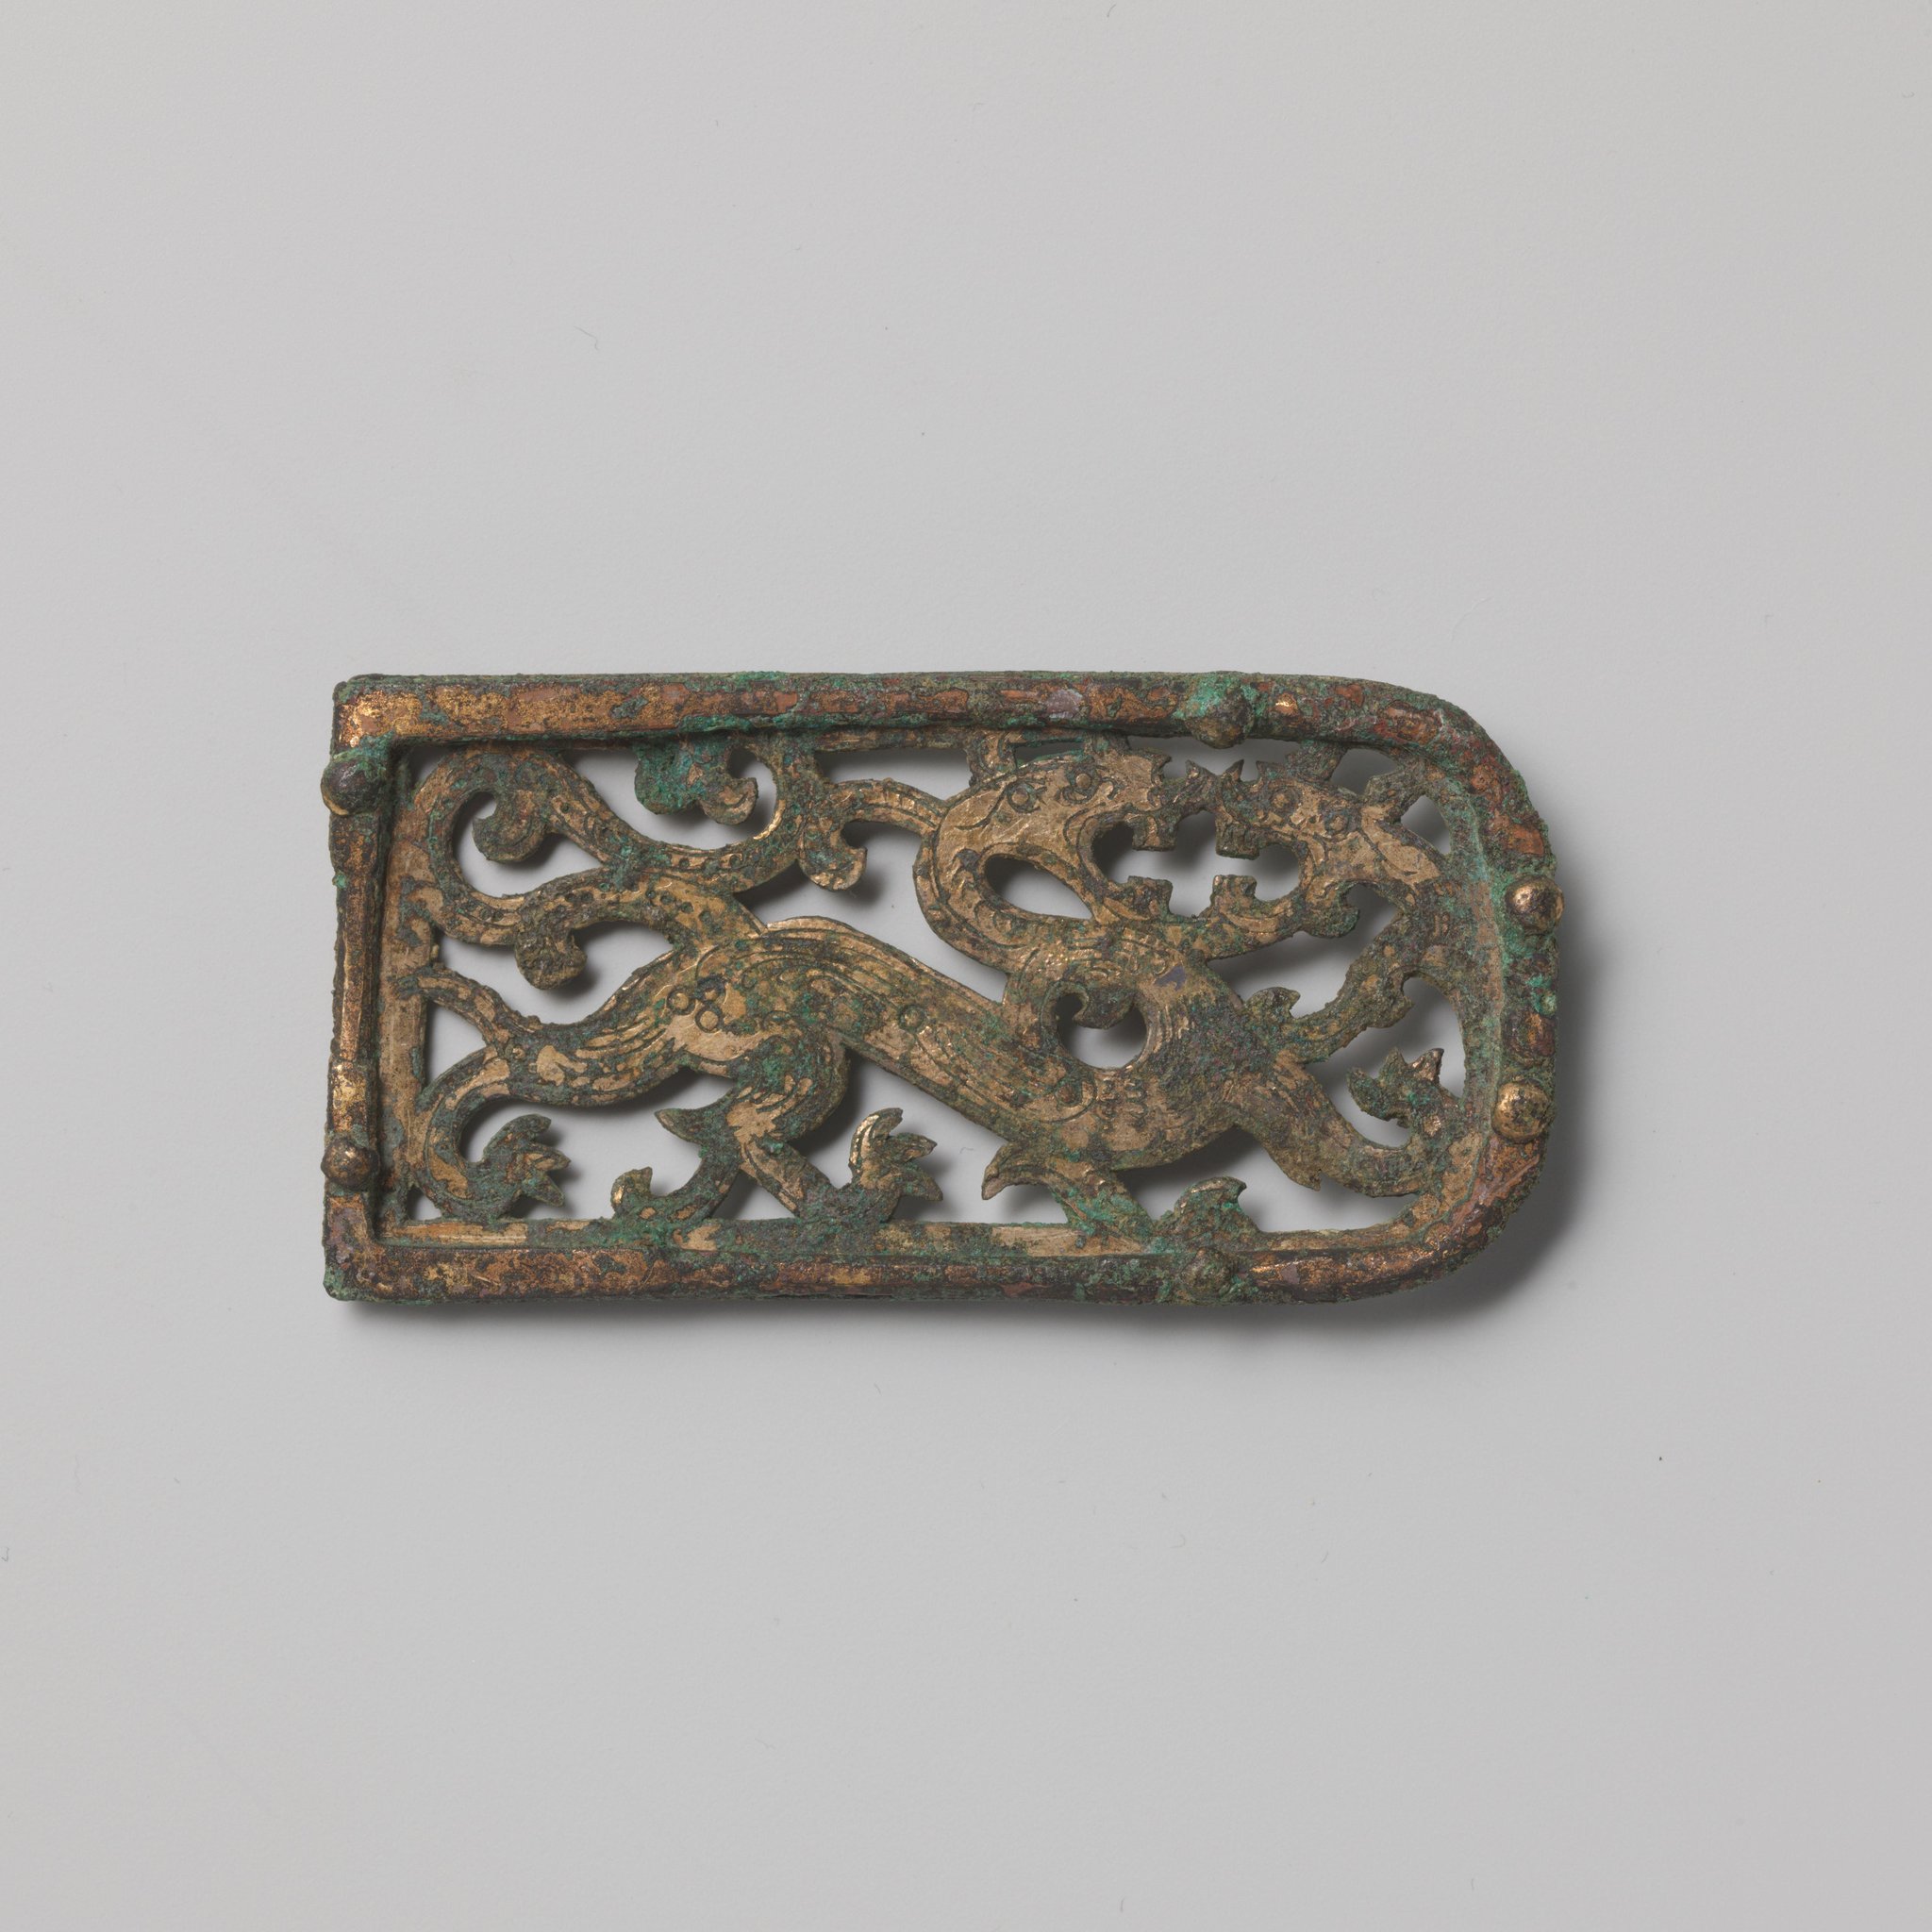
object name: buckle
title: Gesp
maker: Anonymous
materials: bronze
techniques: gilding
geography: china